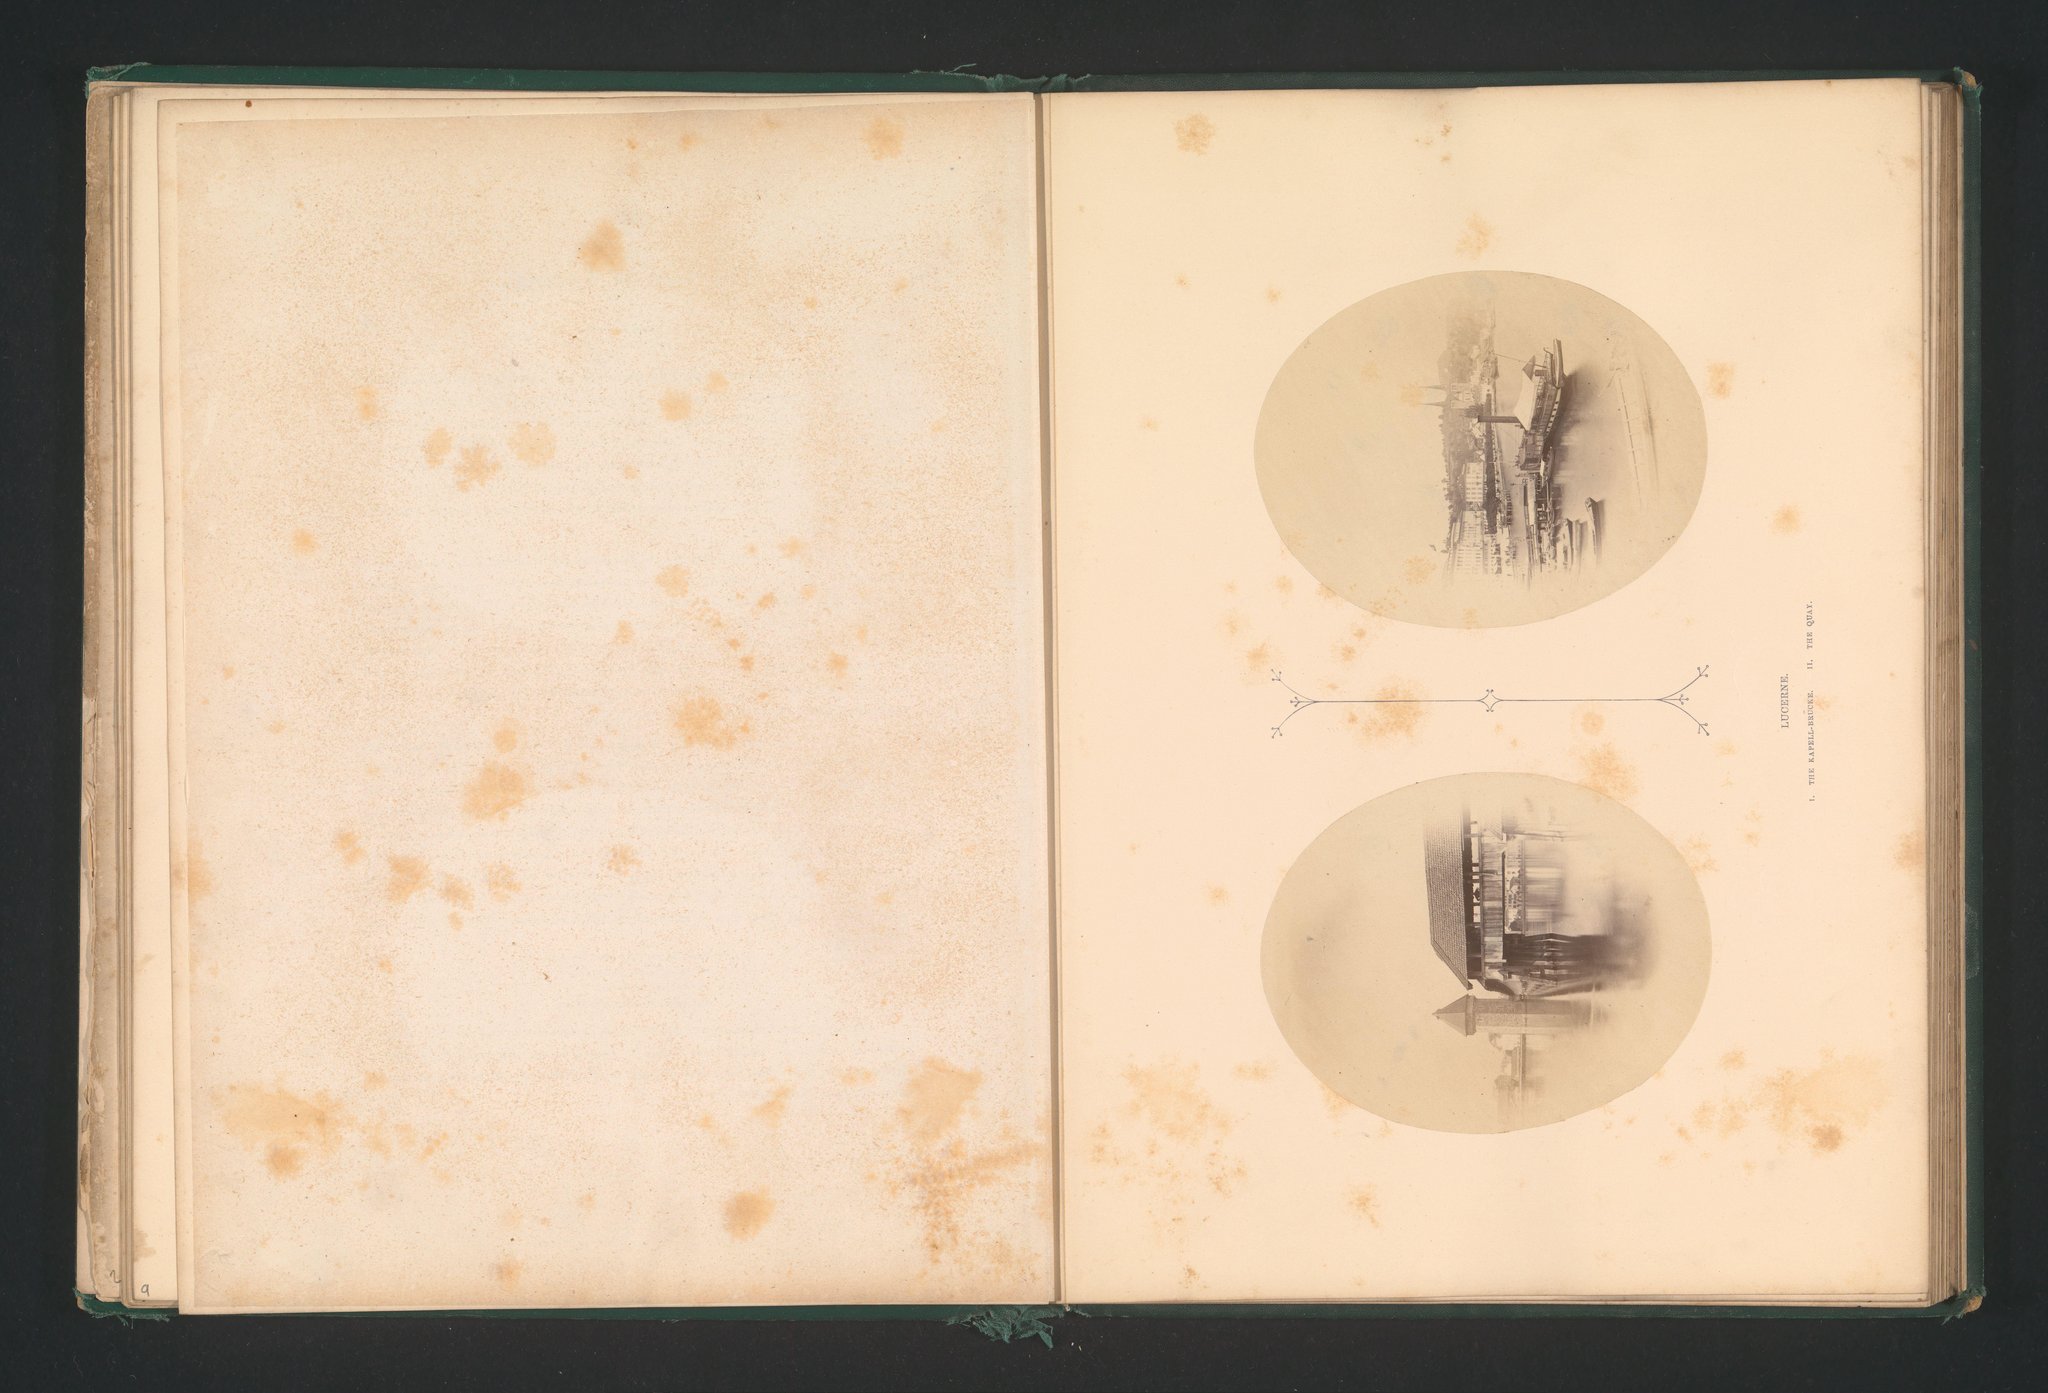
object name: page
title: Lucerne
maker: stephen thompson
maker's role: fotograaf, schrijver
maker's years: 1831-1893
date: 1863-1868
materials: photographic support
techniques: albumen print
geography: lucerne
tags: bridge in city across river, canal, etc.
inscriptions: inscription: ‘I. The Kapell-Brücke’